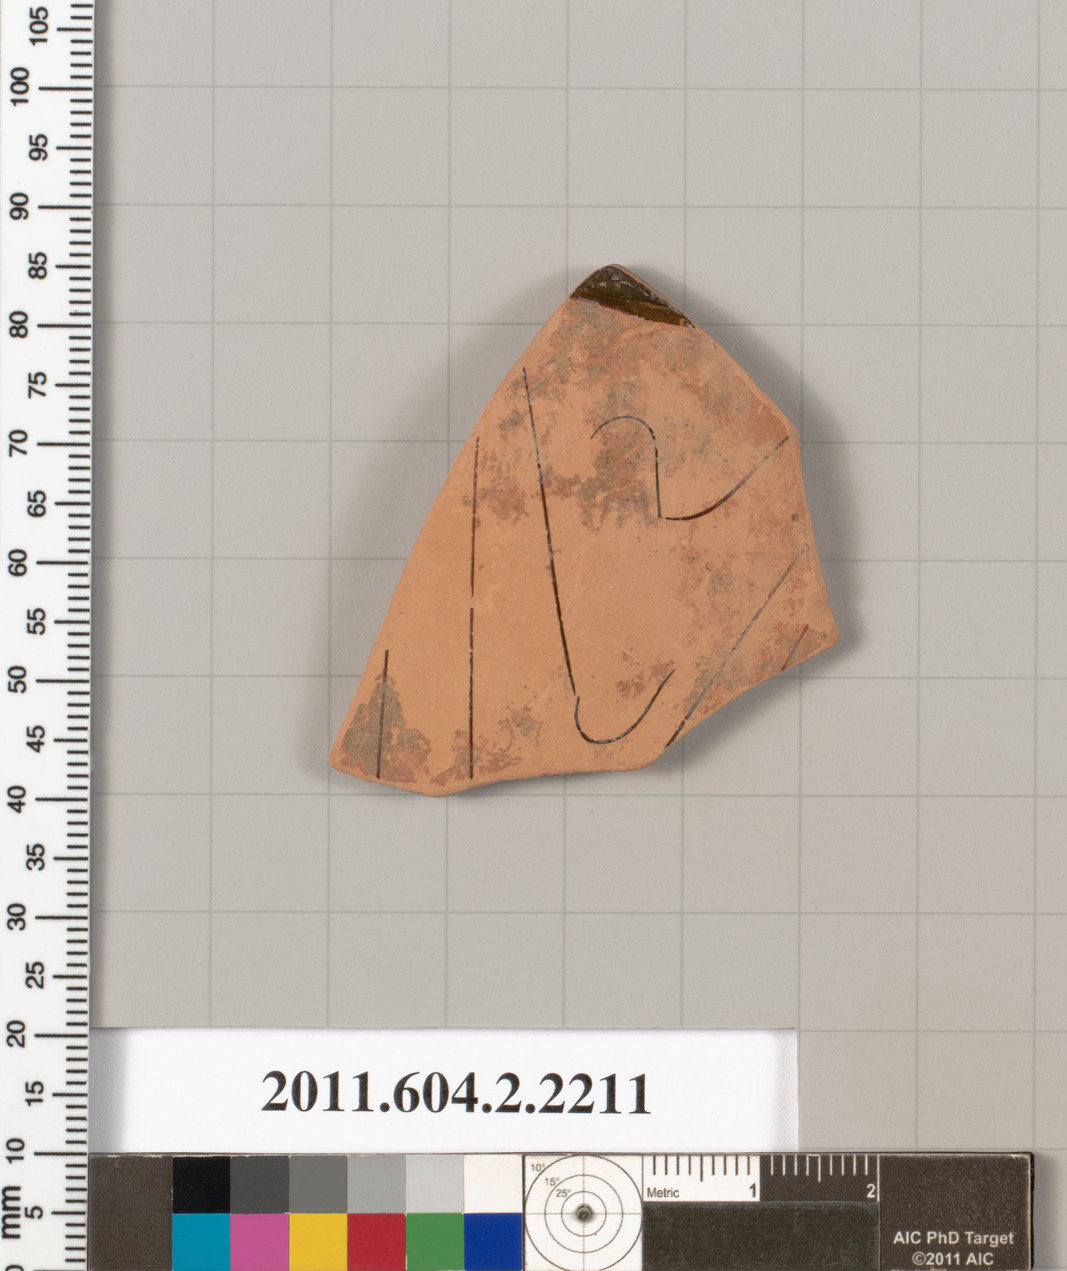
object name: pot fragment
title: Terracotta fragment of a pot; unglazed on the inside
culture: greek, attic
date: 460-450 BCE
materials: terracotta